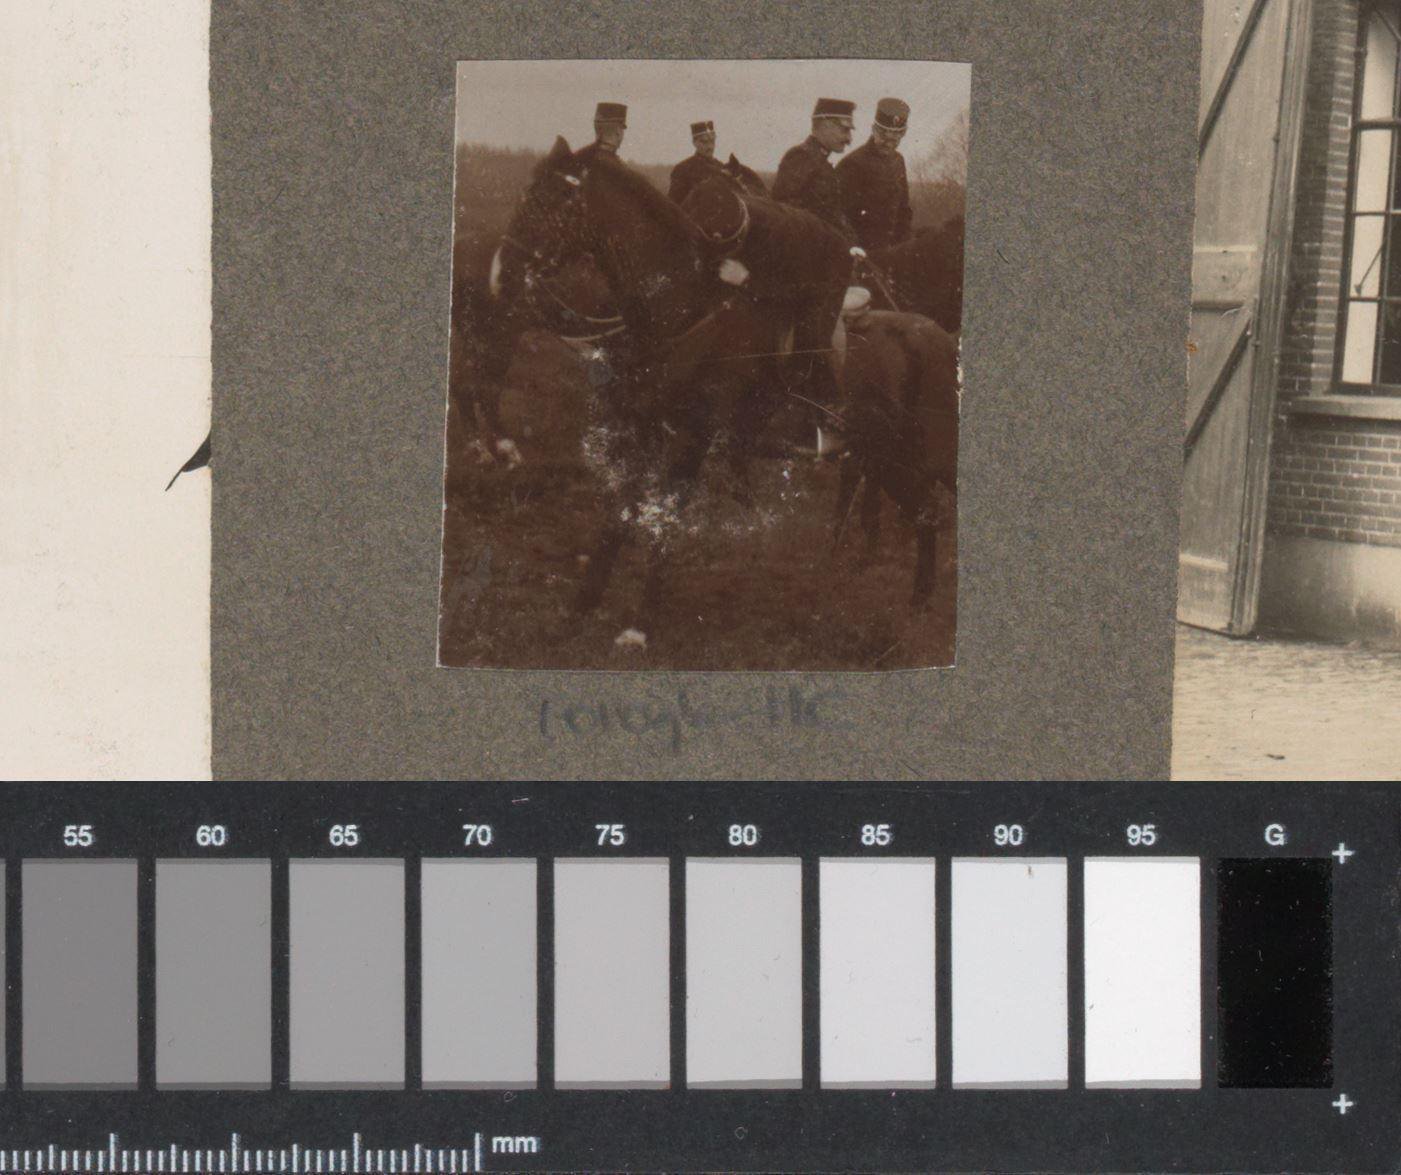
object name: album leaf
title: Ruitertafereel op Koninklijke Houtvesterij Het Loo: groep geüniformeerde ruiters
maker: Anonymous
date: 1900-1925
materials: photographic support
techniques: collodion silver print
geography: het loo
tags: riding a horse, ass, or mule; rider, horseman, hunting, chase, hunting-ground, (military) uniforms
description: Onderdeel van Fotoalbum van de heer Brams, opperhoutvester van koningin Wilhelmina op Koninklijke Houtvesterij Het Loo.